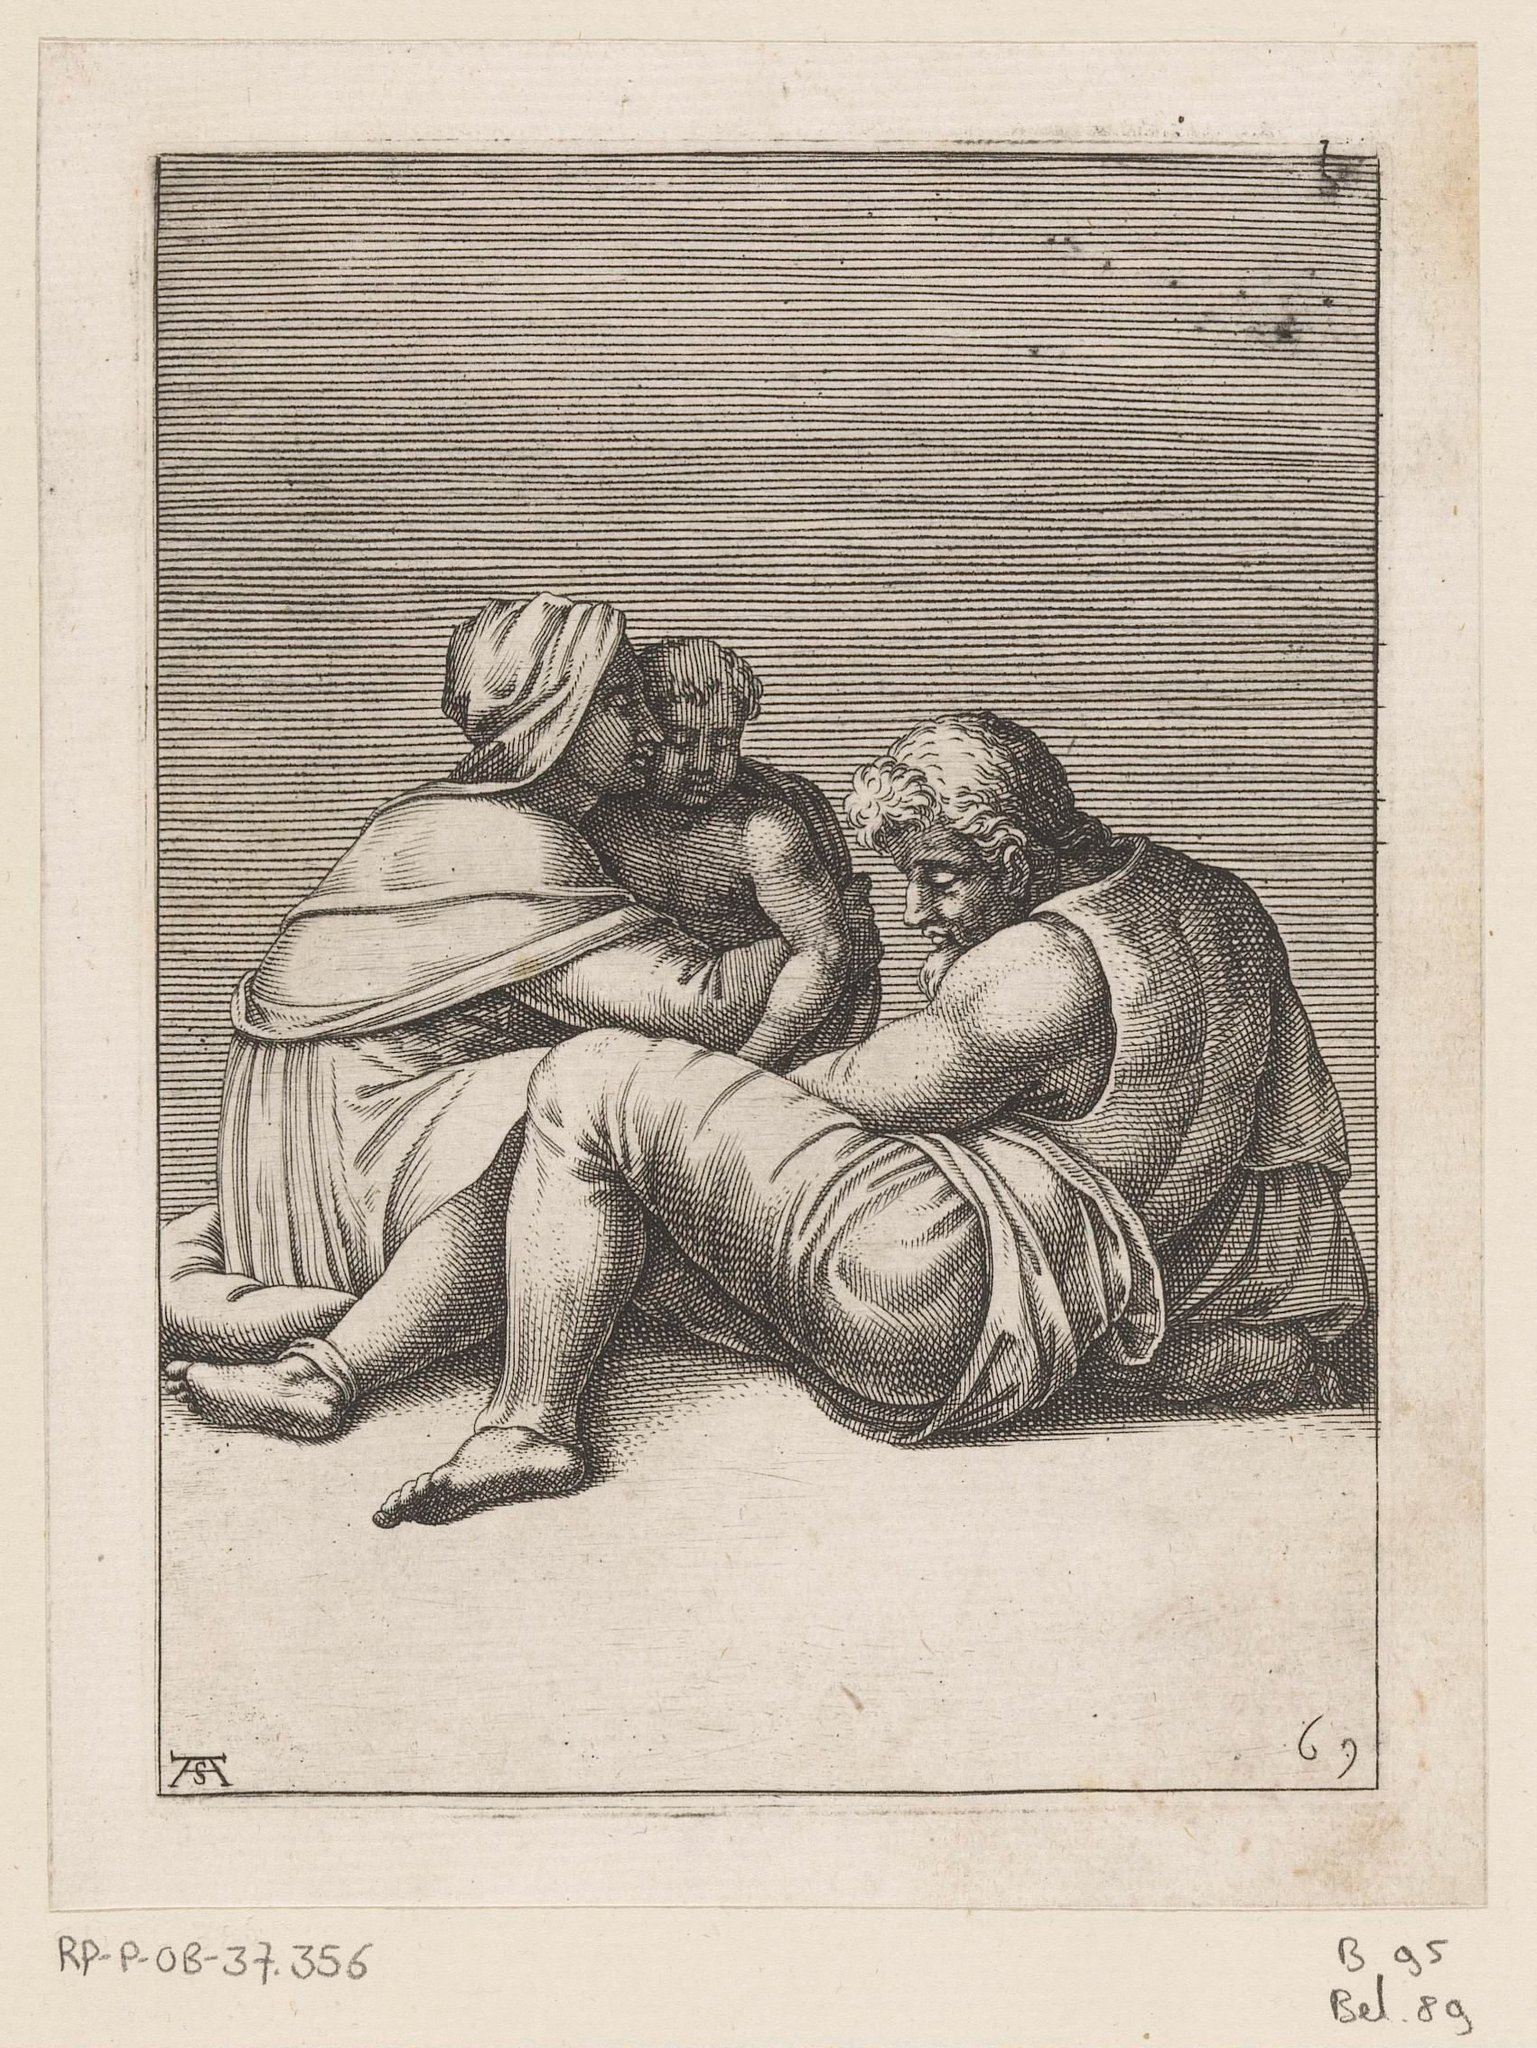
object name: print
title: Man zittend op de grond met vrouw en kind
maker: adamo scultori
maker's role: painter, print maker, sculptor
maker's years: 1530-1585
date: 1585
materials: paper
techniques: engraving, intaglio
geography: vatican city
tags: sitting on the ground, mother and child(ren), woman and child(ren) (family group)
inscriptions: collector's mark: Lugt 240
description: Deze prent maakt deel uit van een serie bestaande uit een titelprent en 72 prenten naar schilderingen door Michelangelo in de Sixtijnse Kapel in het Vaticaan.